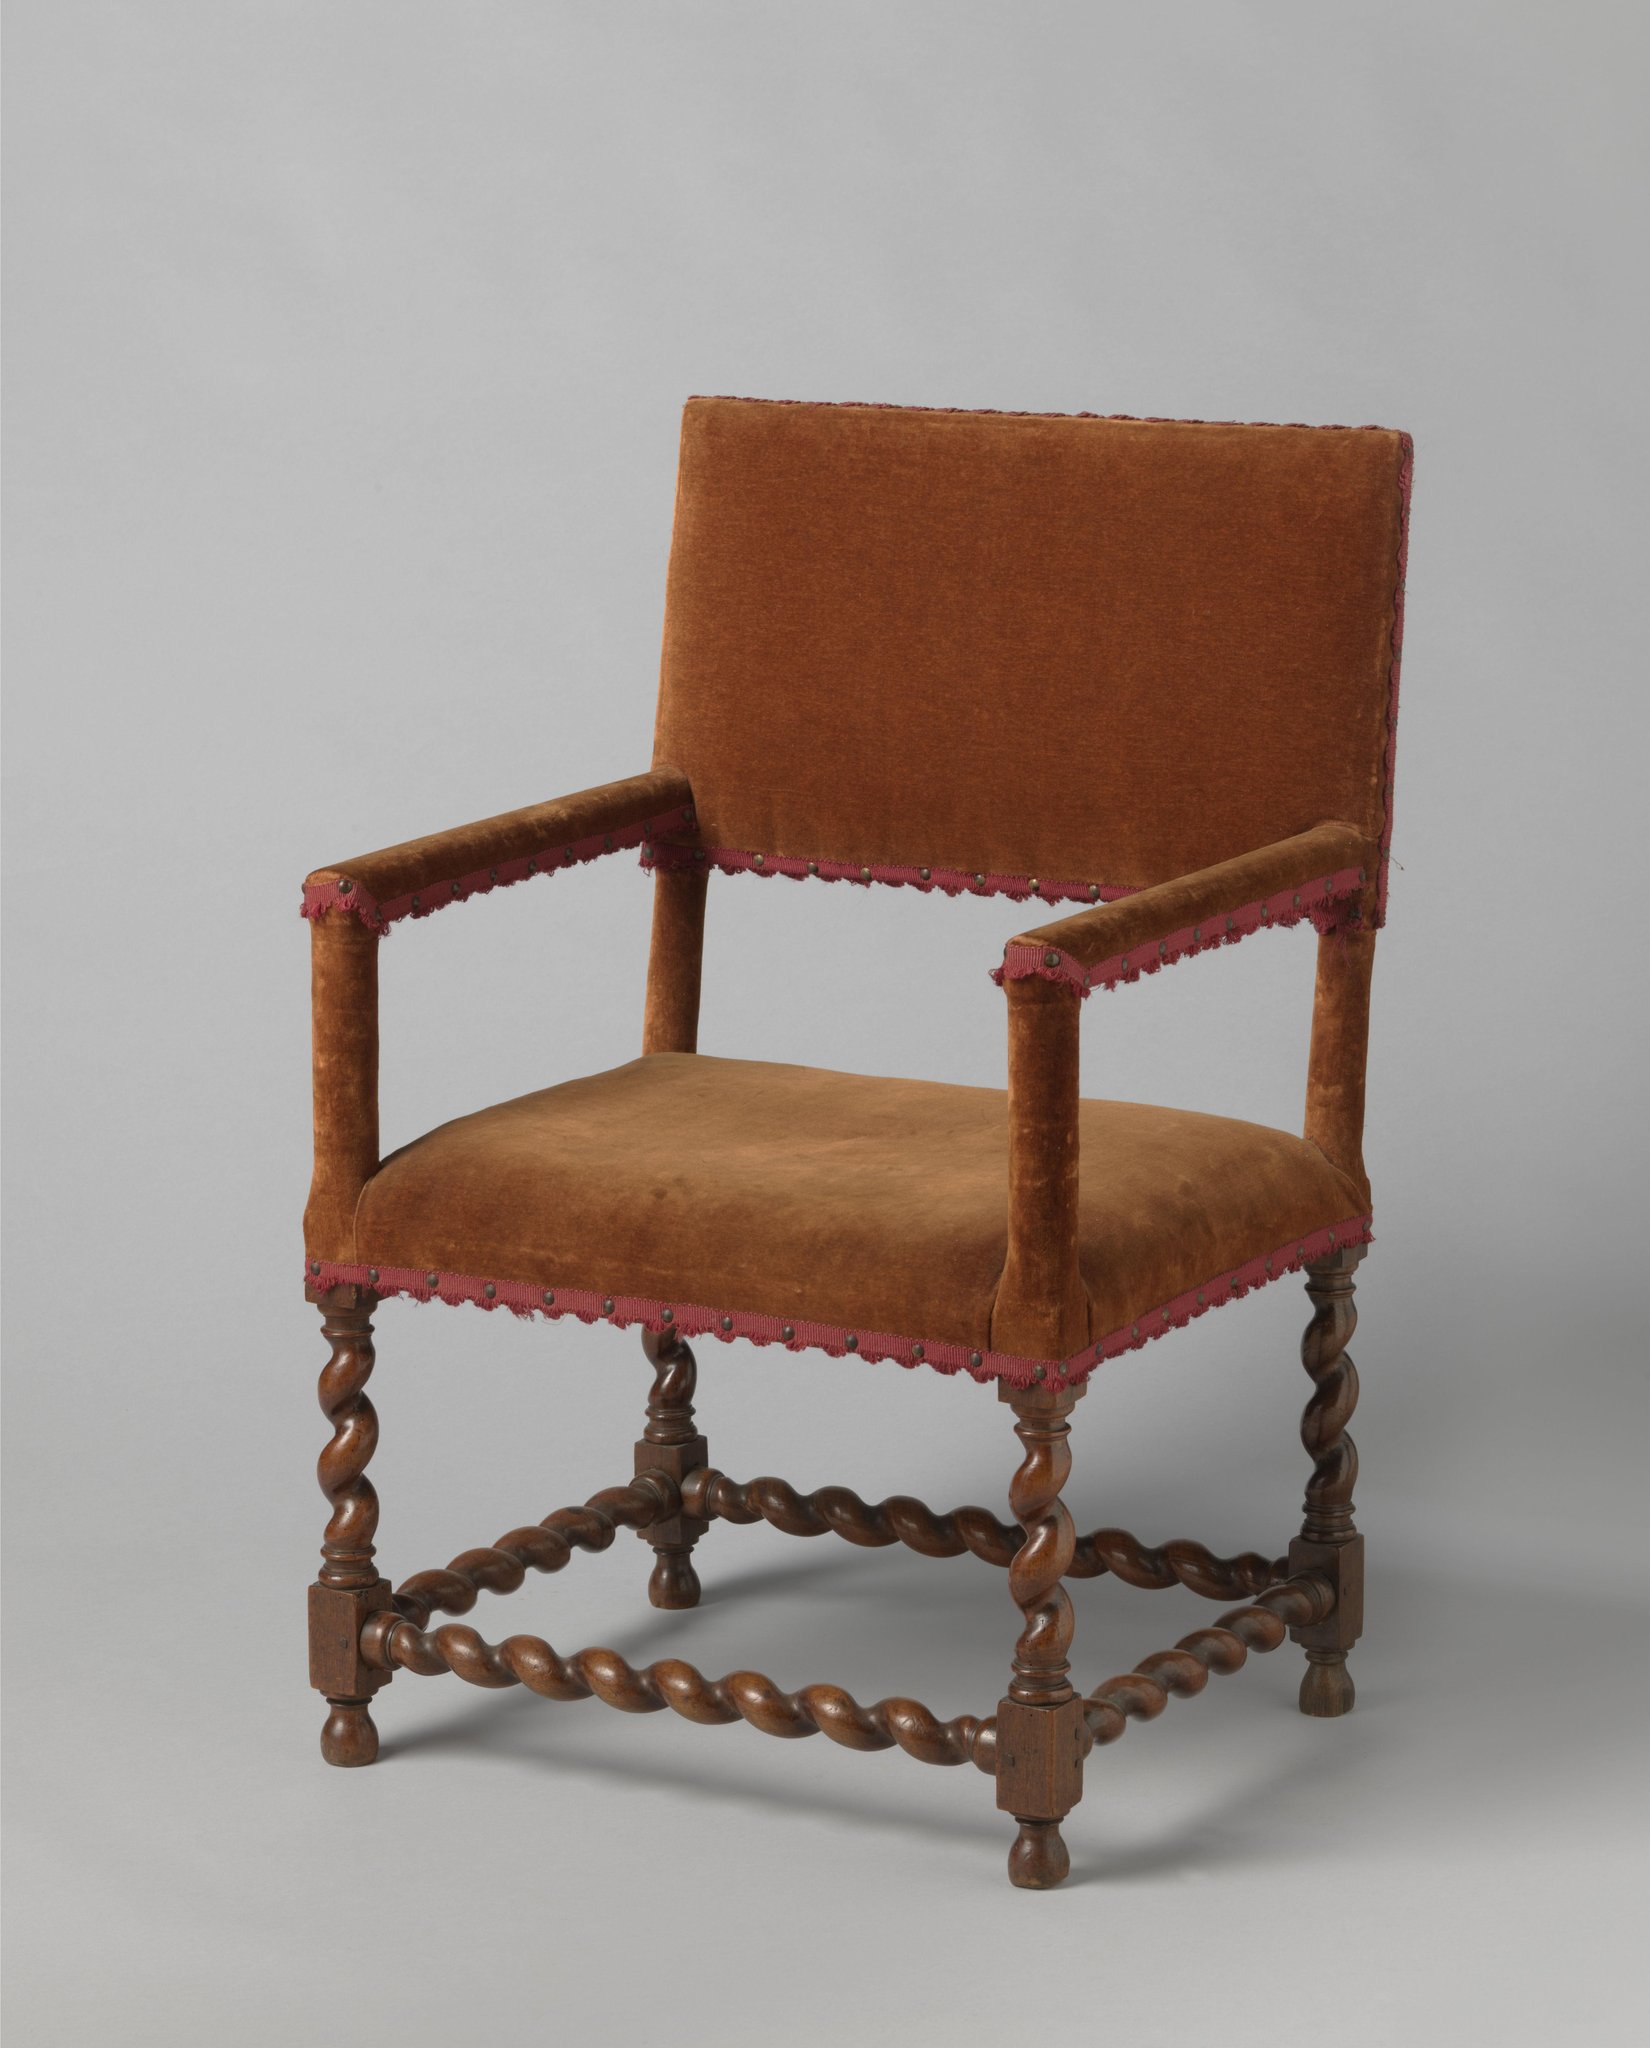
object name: furniture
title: Armstoel met geslingerde poten en sporten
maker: Anonymous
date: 1640-1660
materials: wood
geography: northern netherlands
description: Armstoel van notenhout. Het meubel is bekleed en heeft geslingerde poten door vier eveneens gelingerde ondersporten verbonden. De armleggerstutten en de ruggestutten zijn omkleed en afgerond, evenals de rechte armleggers.